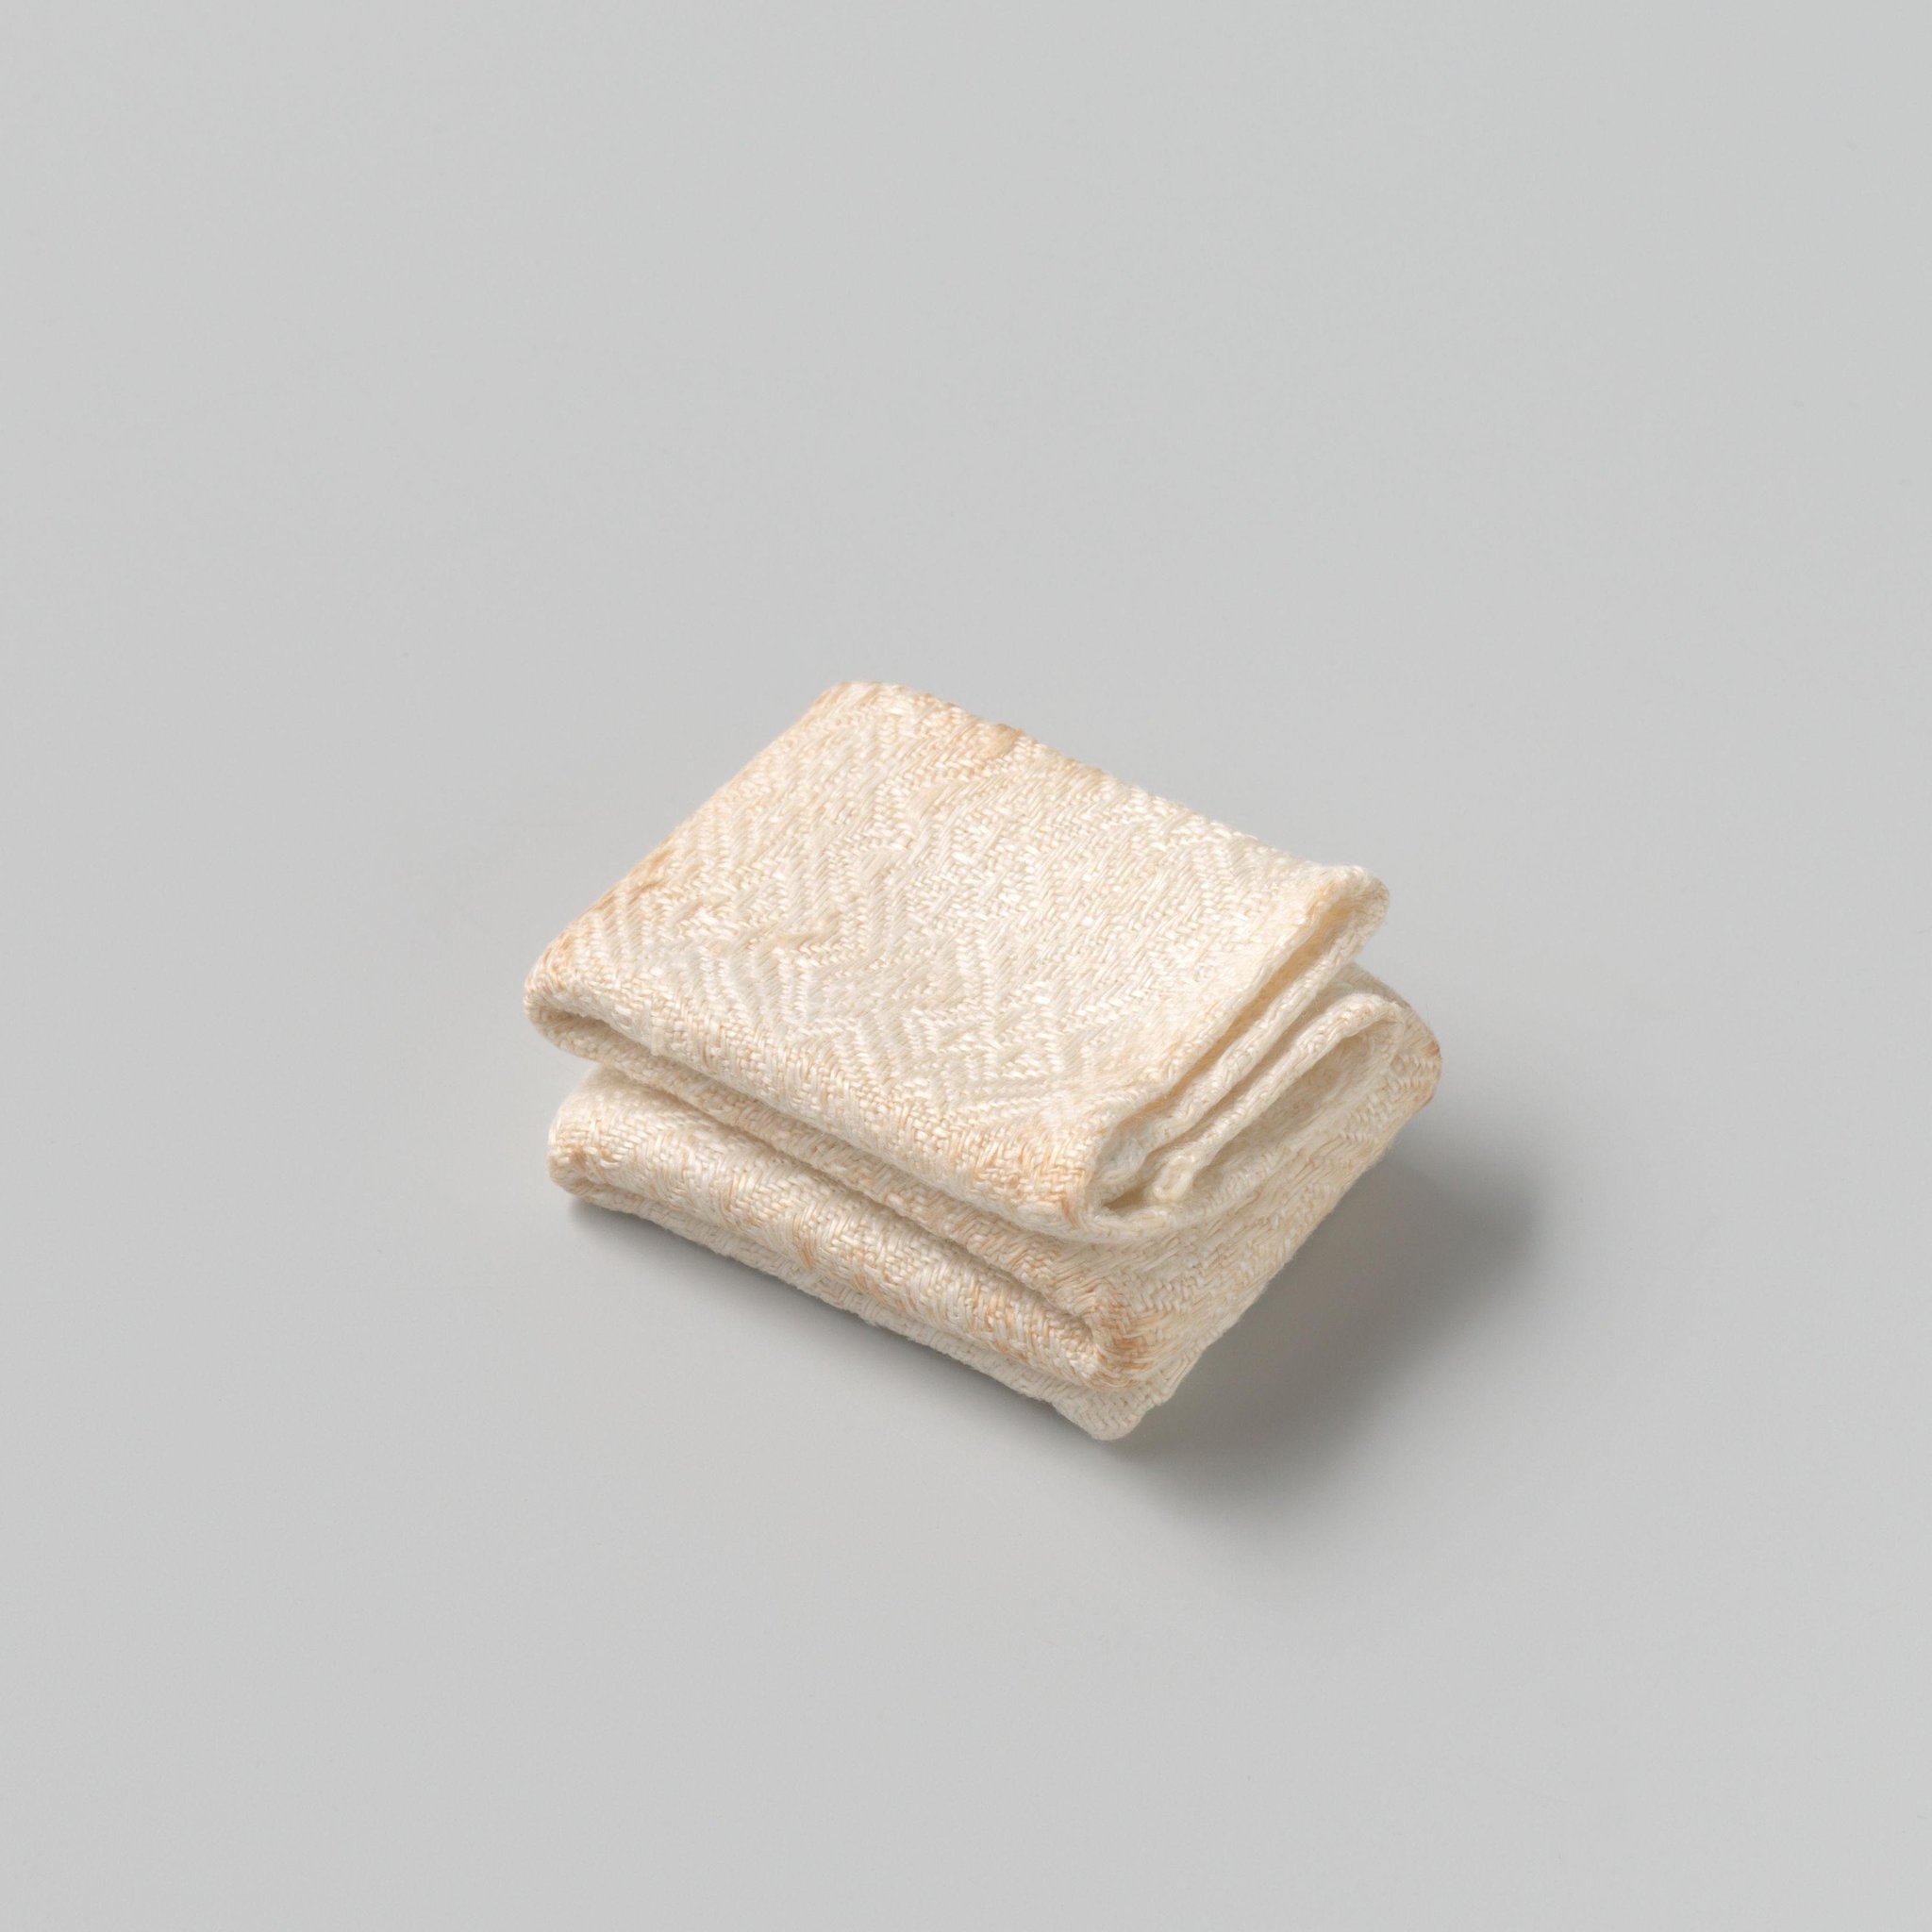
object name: miniature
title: Servet, damastweefsel met pellenpatroon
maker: Anonymous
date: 1600-1699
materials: linen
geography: netherlands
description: Servet, damastweefsel met een pellenpatroon, geknipt uit grotere stukken linnen en aan alle kanten omgezoomd met een fijne zoom.